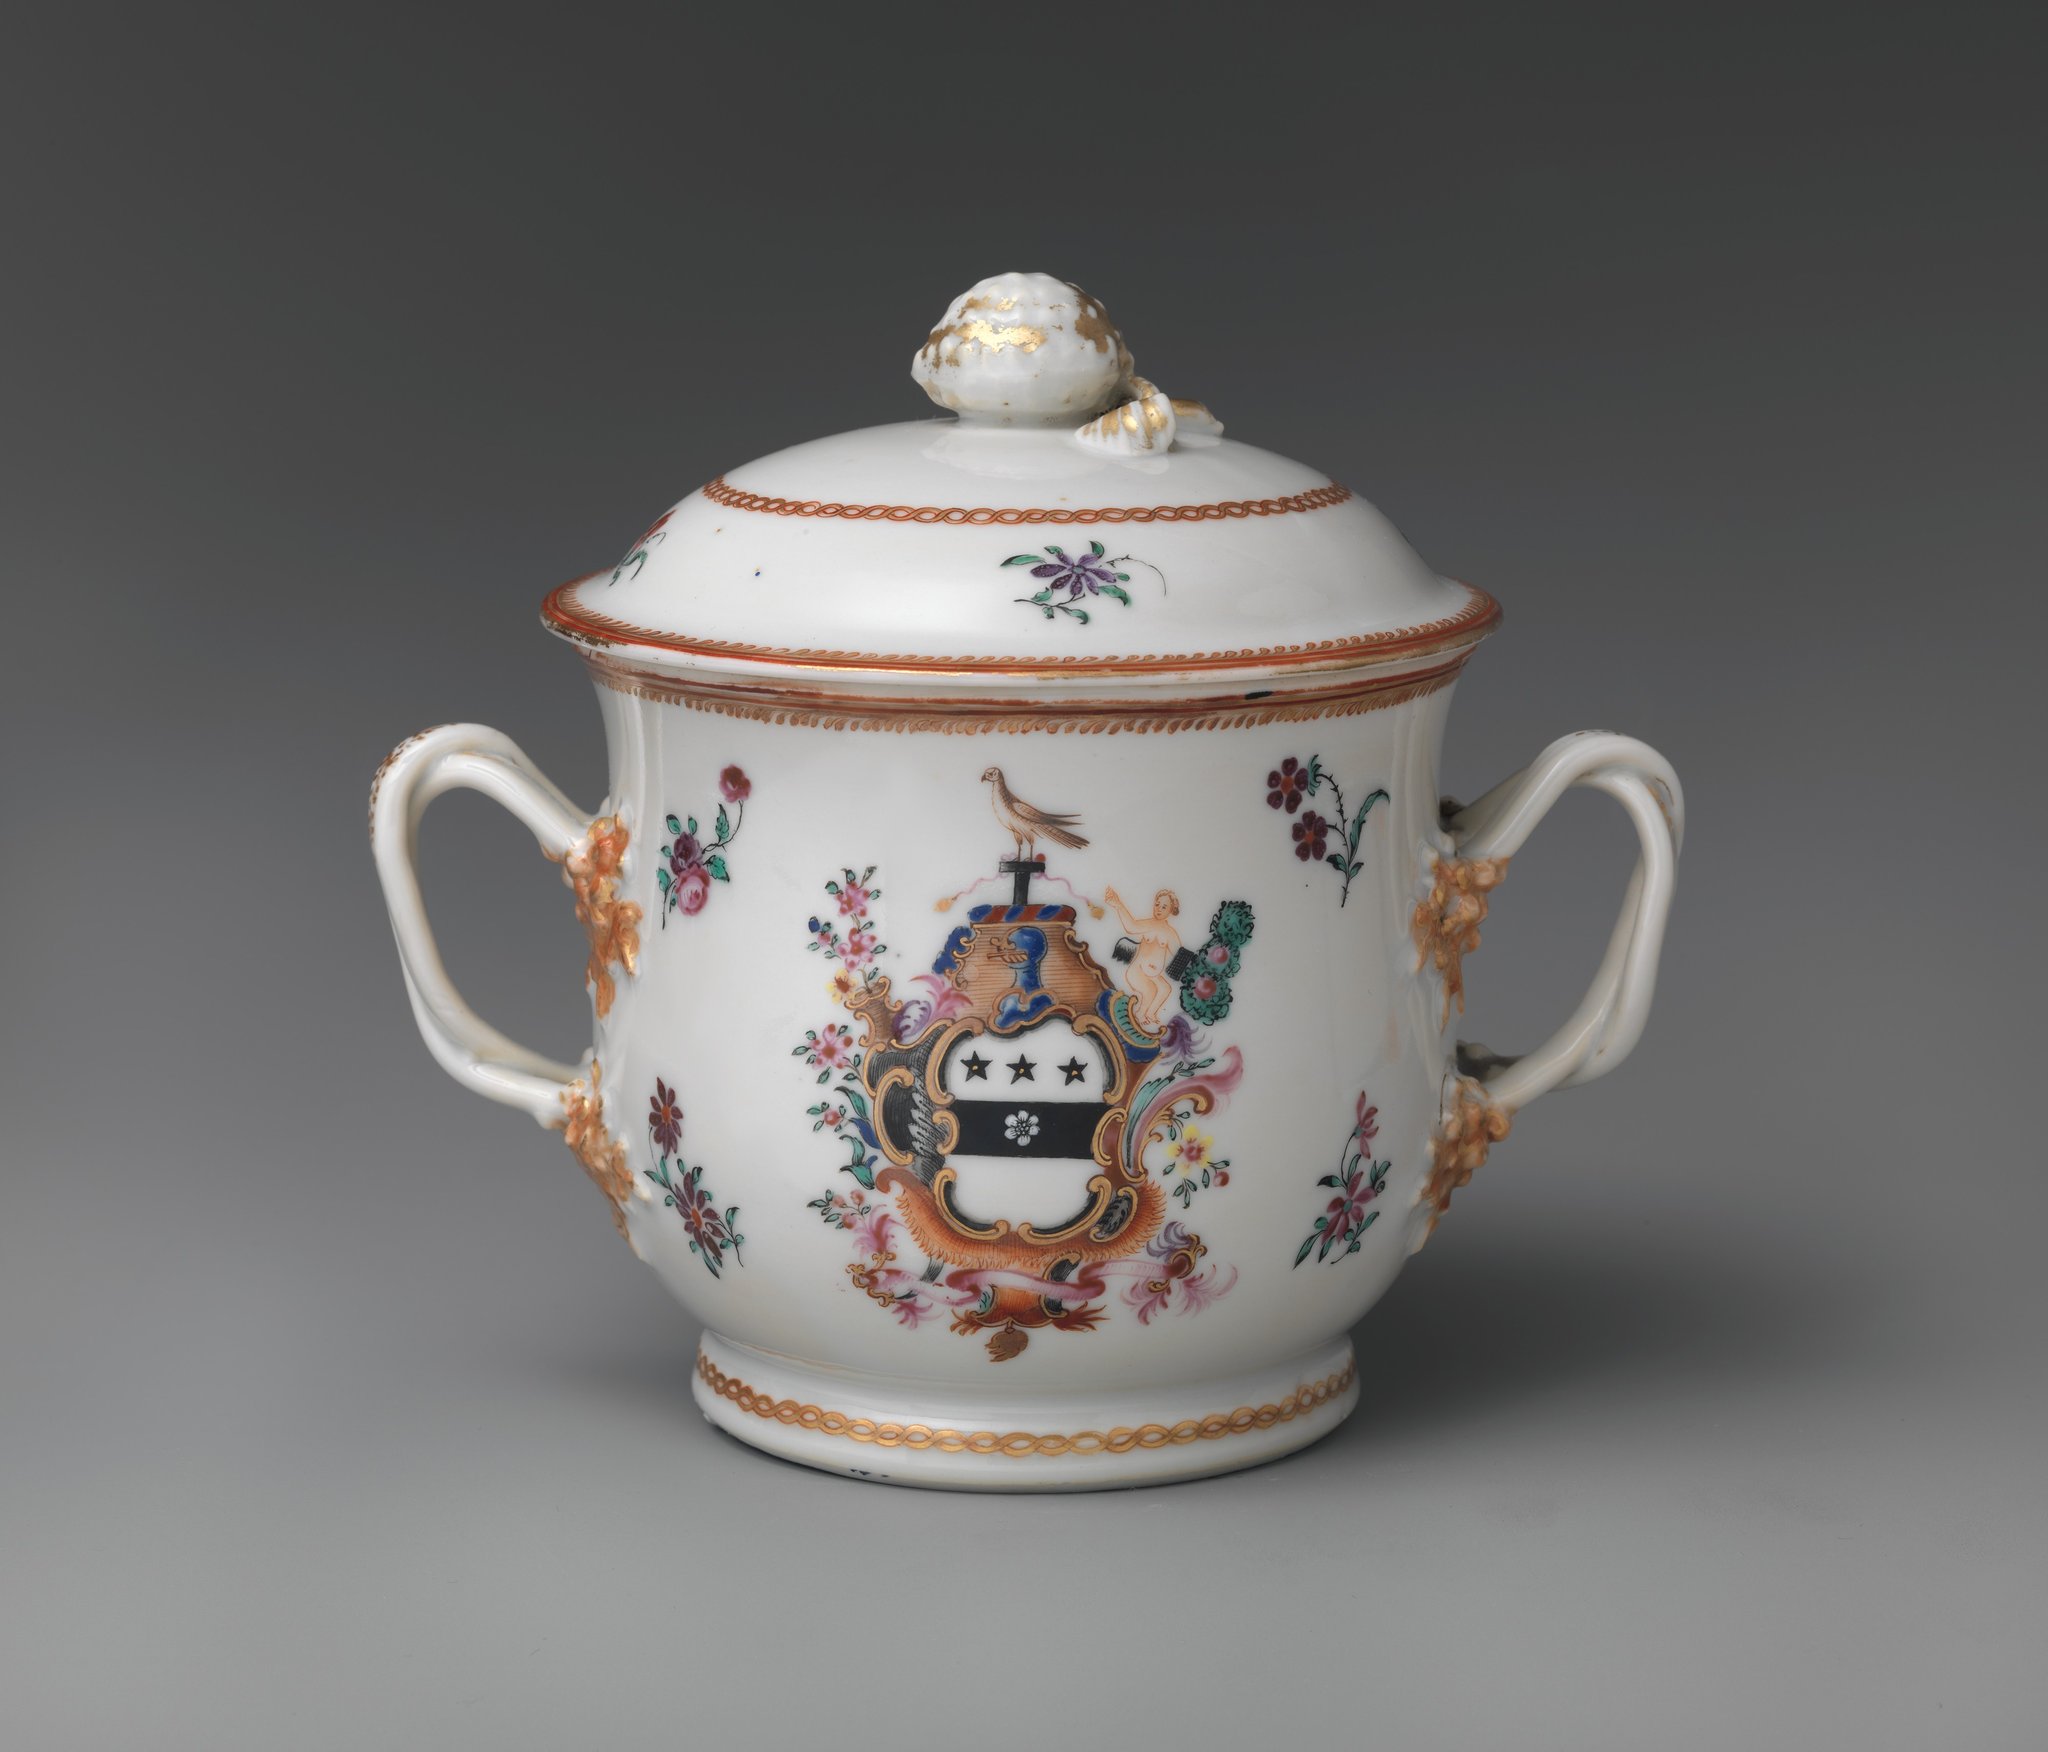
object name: bowl and tray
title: Covered Two-handled Bowl and Tray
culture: chinese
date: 1785-1790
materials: hard paste porcelain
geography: china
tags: birds,coat of arms